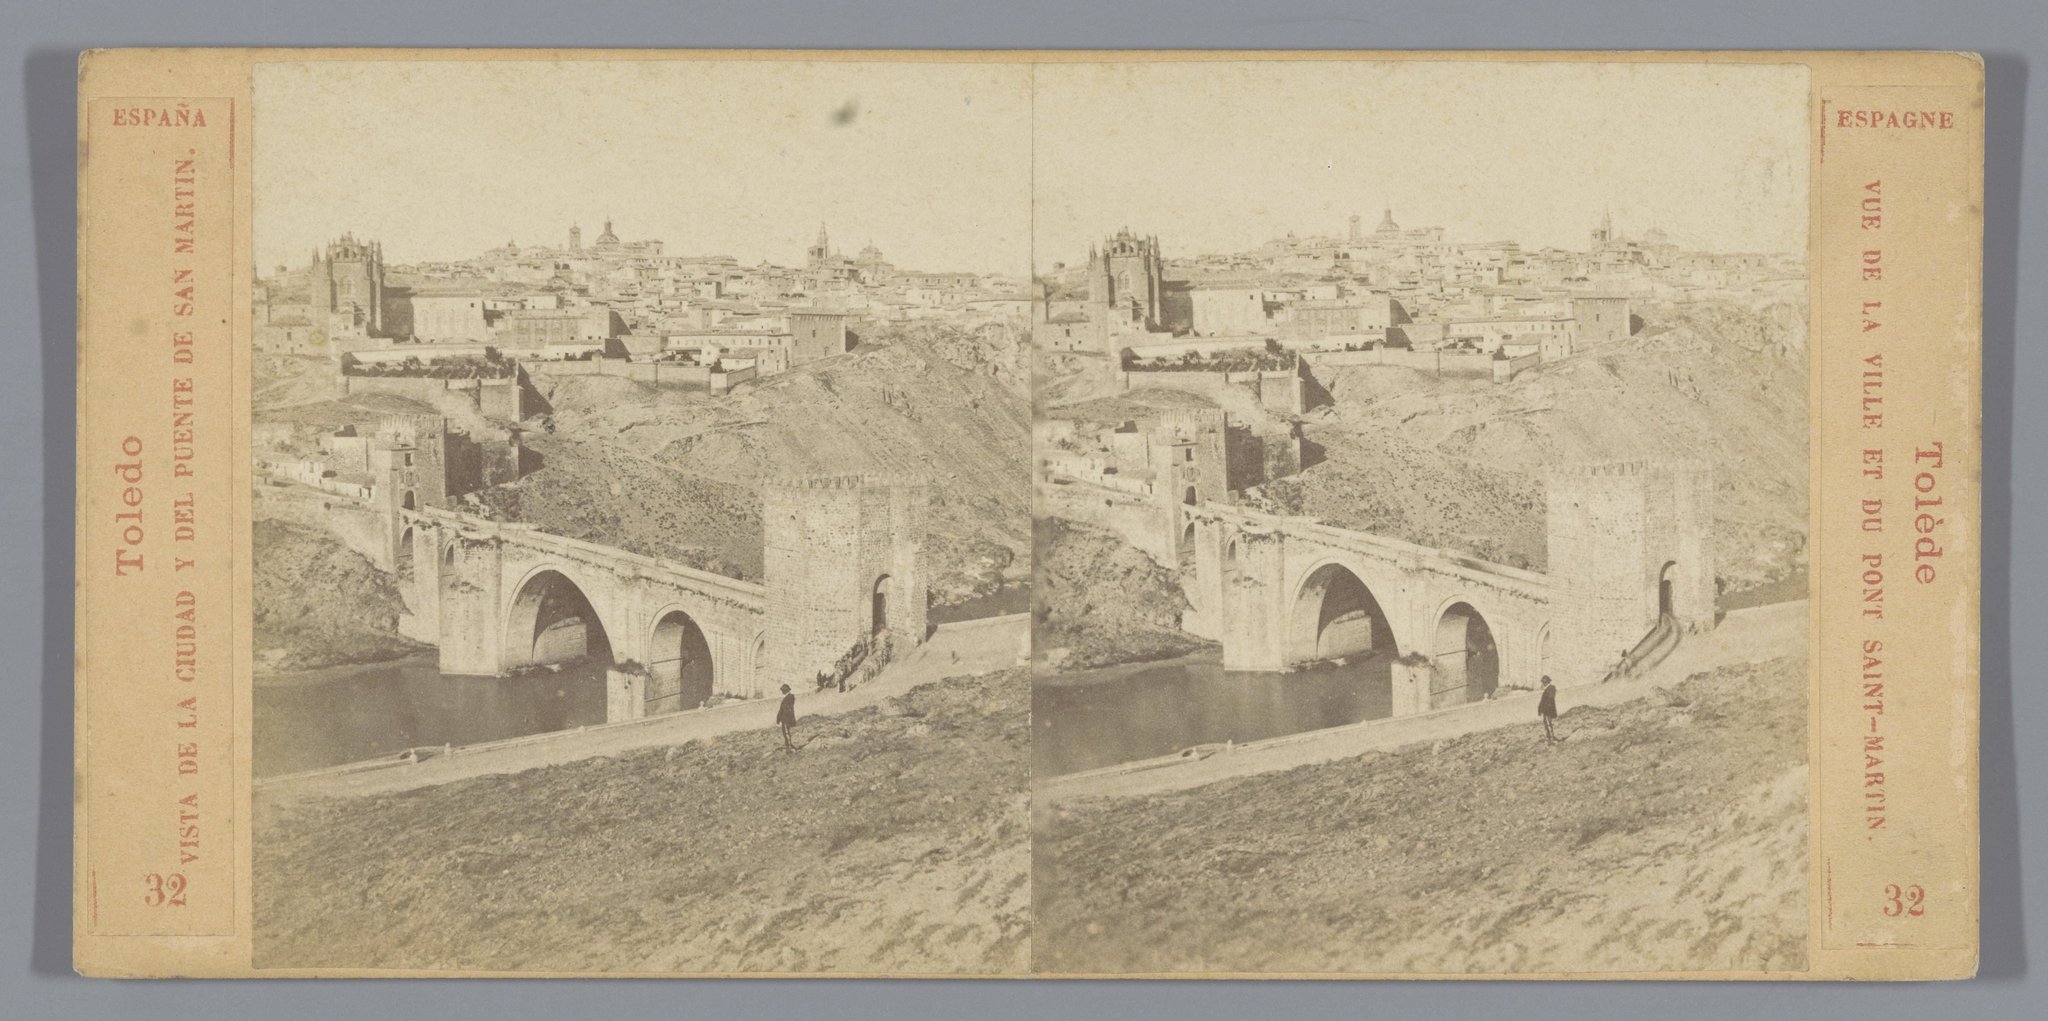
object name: stereograph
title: Gezicht op Toledo en de Puente de San Martín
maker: Anonymous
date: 1850-1880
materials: cardboard, photographic support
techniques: albumen print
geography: castilla-la mancha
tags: city-view in general; 'veduta'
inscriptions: inscription: ‘España’, number: ‘32’